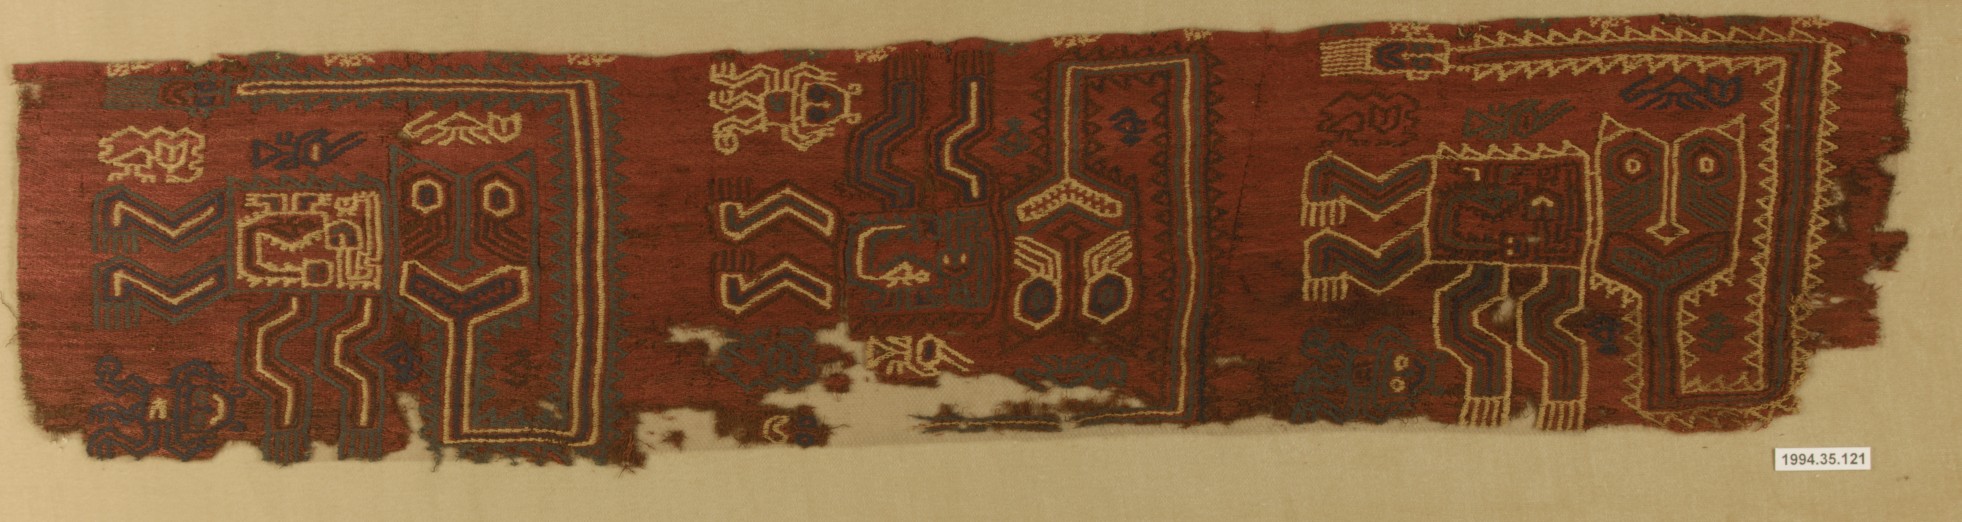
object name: border fragment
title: Embroidered Border Fragment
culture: peruvian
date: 1-700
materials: animal fiber, cotton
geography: peru